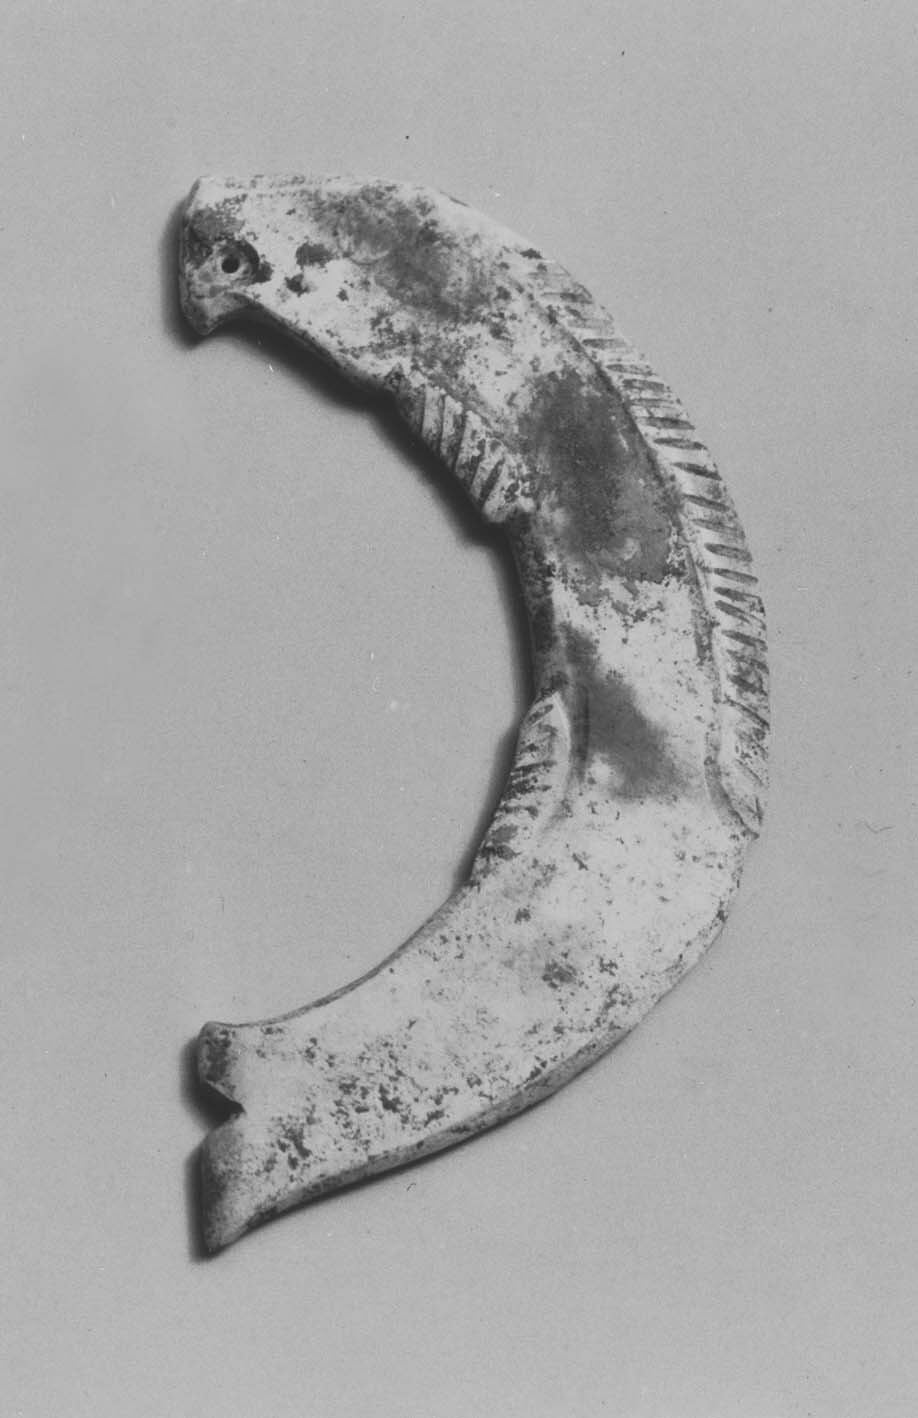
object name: plaque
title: Plaque in the shape of a fish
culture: chinese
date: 1600-771 BCE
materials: jade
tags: fish